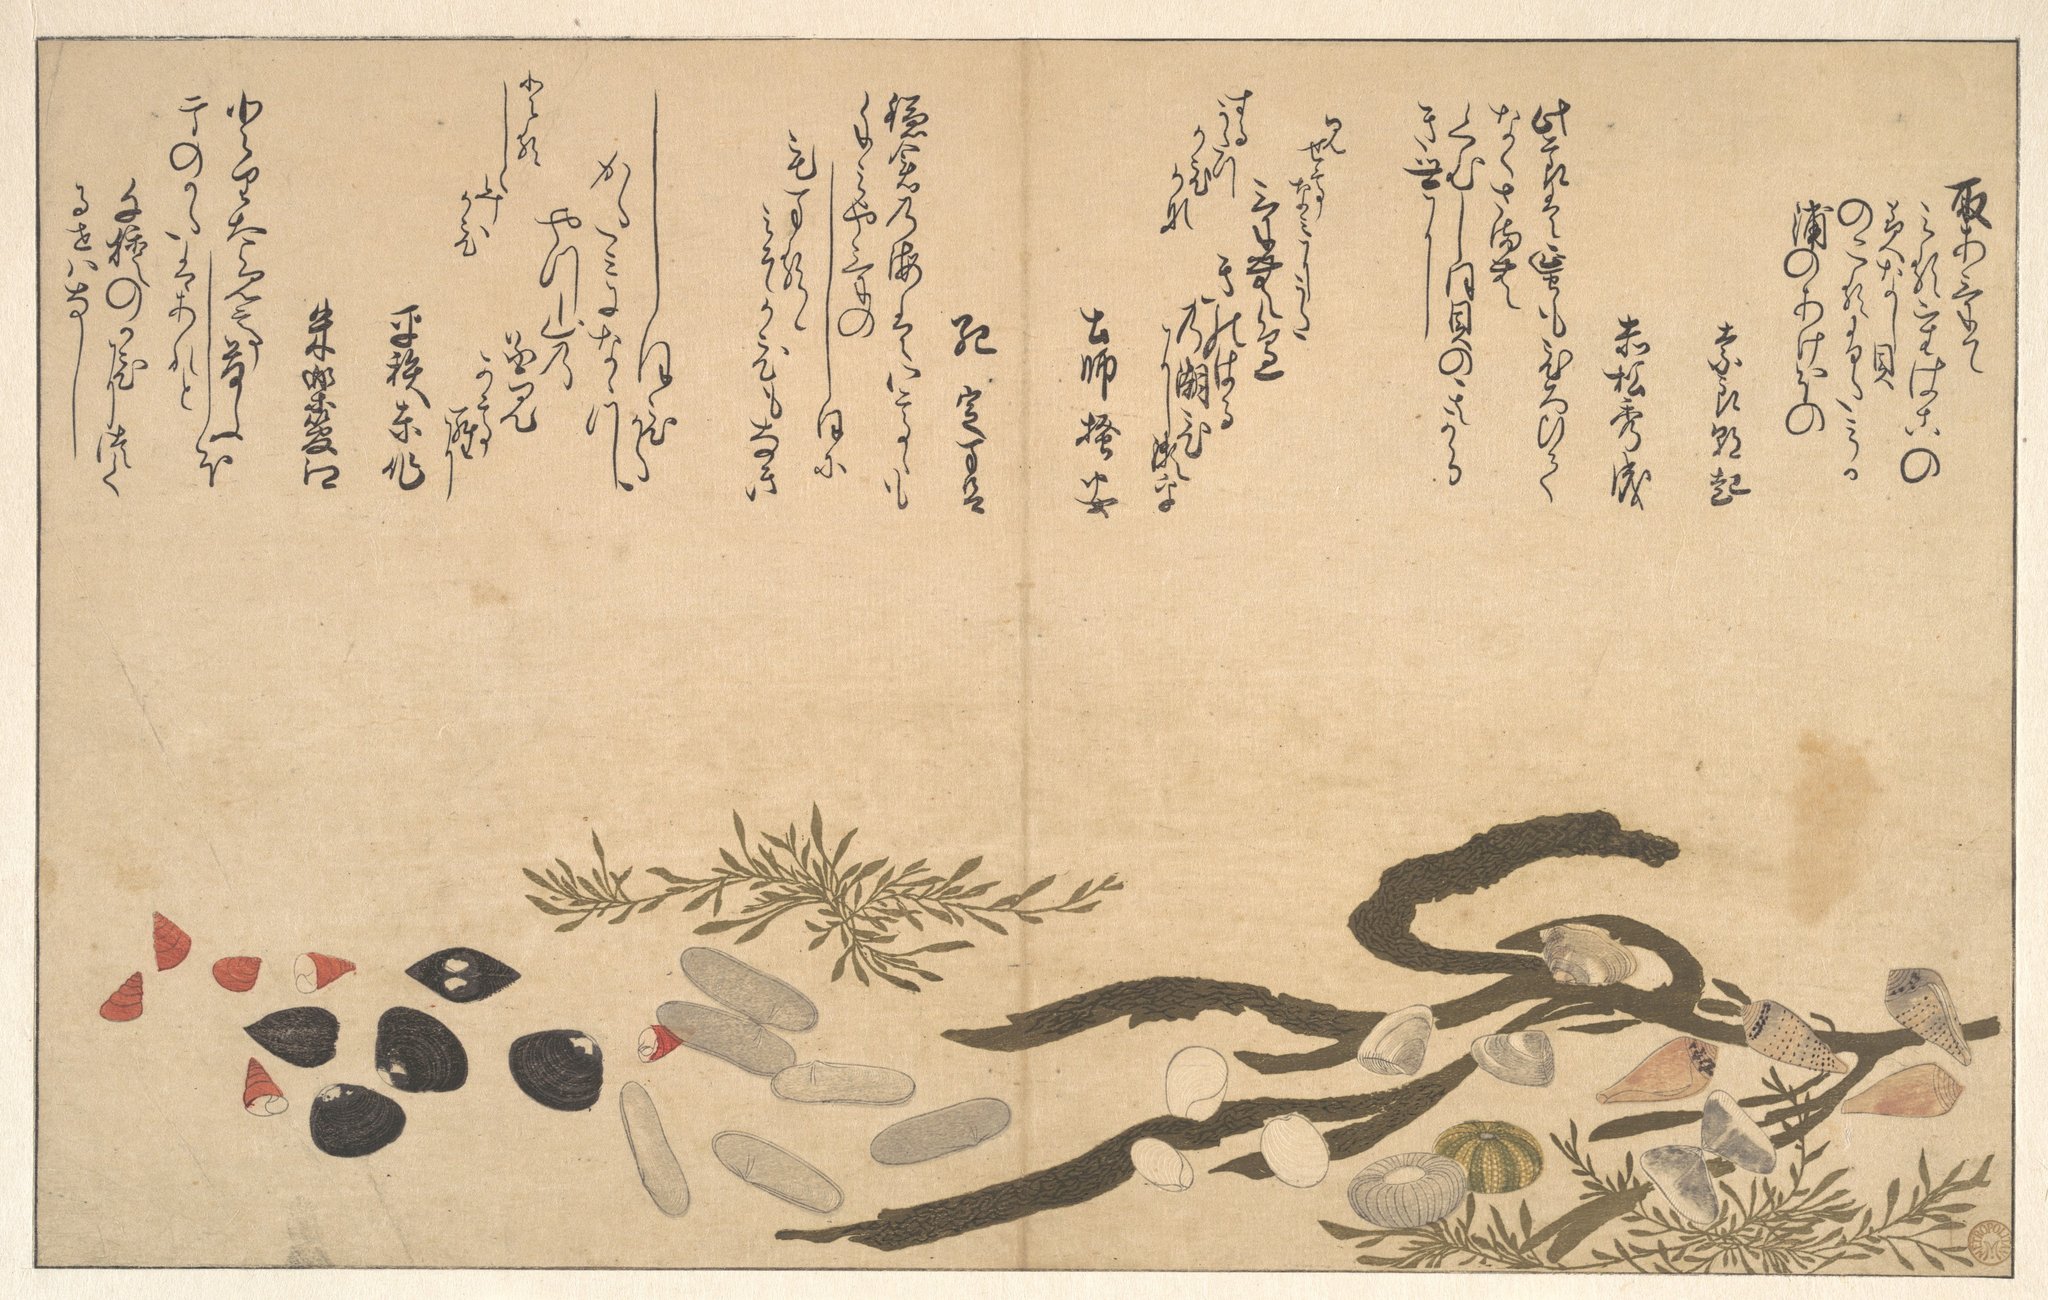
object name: print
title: Shells under Water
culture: japanese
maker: kitagawa utamaro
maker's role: artist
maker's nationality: japanese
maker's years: 1754-1806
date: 1790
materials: ink, paper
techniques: woodblock print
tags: plants,shells